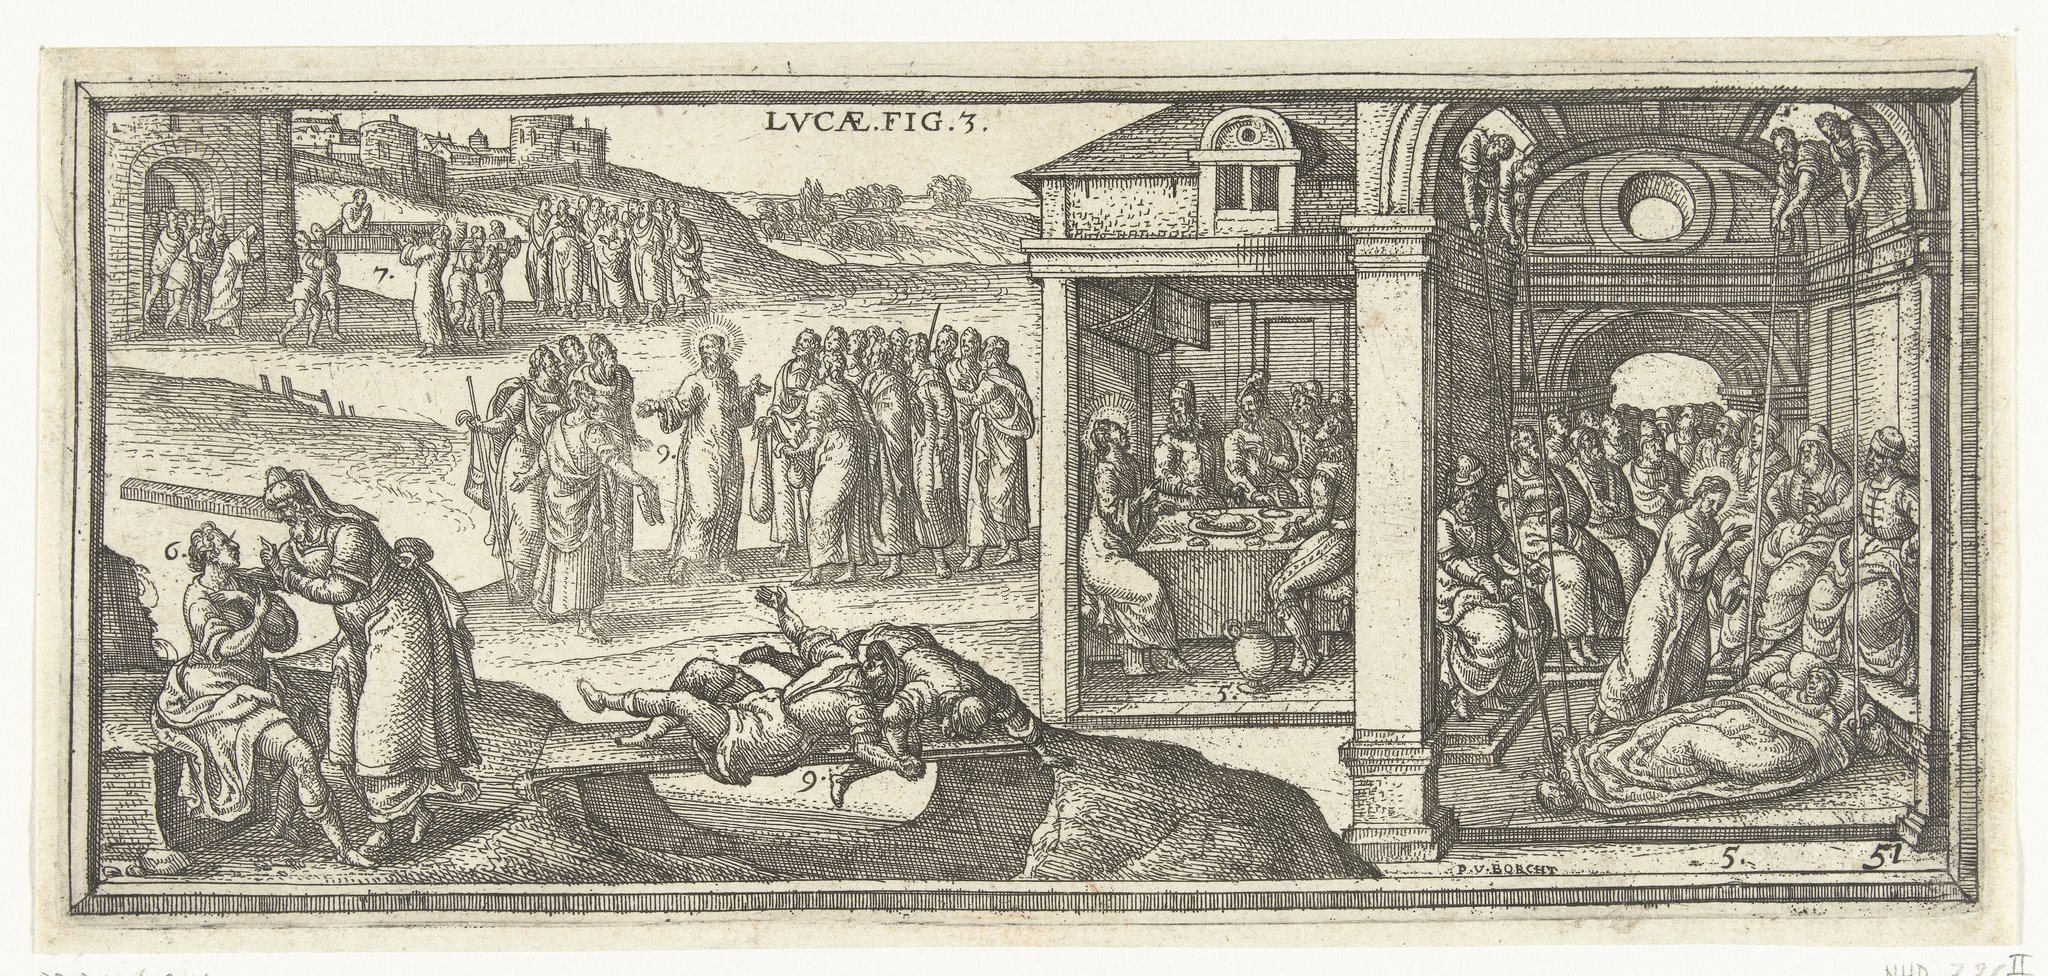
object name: print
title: Bijbelse taferelen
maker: pieter van der borcht (i)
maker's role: print maker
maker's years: 1545-1608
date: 1582-1592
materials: paper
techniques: etching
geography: antwerp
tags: the blind leading the blind (matthew 15:14), christ touches the bier of the son of the widow of nain: the young man sits up, a paralytic on his bed is brought to the house where christ is preaching (matthew 9:1-8; mark 2:1-12; luke 5:17-26), meal at the house of levi (matthew) (matthew 9:10-13; mark 2:15-17; luke 5:29-32), christ sends apostles out in pairs (matthew 10:1-16; mark 6:7-11; luke 9:1-5), the mote and the beam in the eye ~ doctrine of christ on love, etc. (matthew 7:4; luke 6:42)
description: Verschillende taferelen over het leven van Christus uit het evangelie van Lucas . De taferelen zijn genummerd op passage. Uiterst rechts van de prent geneest Christus een verlamde man die op een draagbed werd neergelaten door zijn vrienden (Lucas 5:17-26). Daarnaast bezoekt Christus het huis van tollenaar Levi en heeft er een feestmaal (Lucas 5:27-39). Op de voorgrond en links van de prent worden enkele van Christus zijn spreuken verbeeld. Op de voorgrond vallen twee blinden in een kuil (Lucas 6:39). Links wordt een jongen met een splinter in zijn oog berispt door een oudere man met een balk in zijn oog (Lucas 6:41-42). Op de achtergrond brengt Christus de dode zoon van een weduwe uit Naïn terug tot leven (Lucas 7:11-17). In het midden van de prent zendt Christus de twaalf apostelen uit op missie (Lucas 9:1-6).